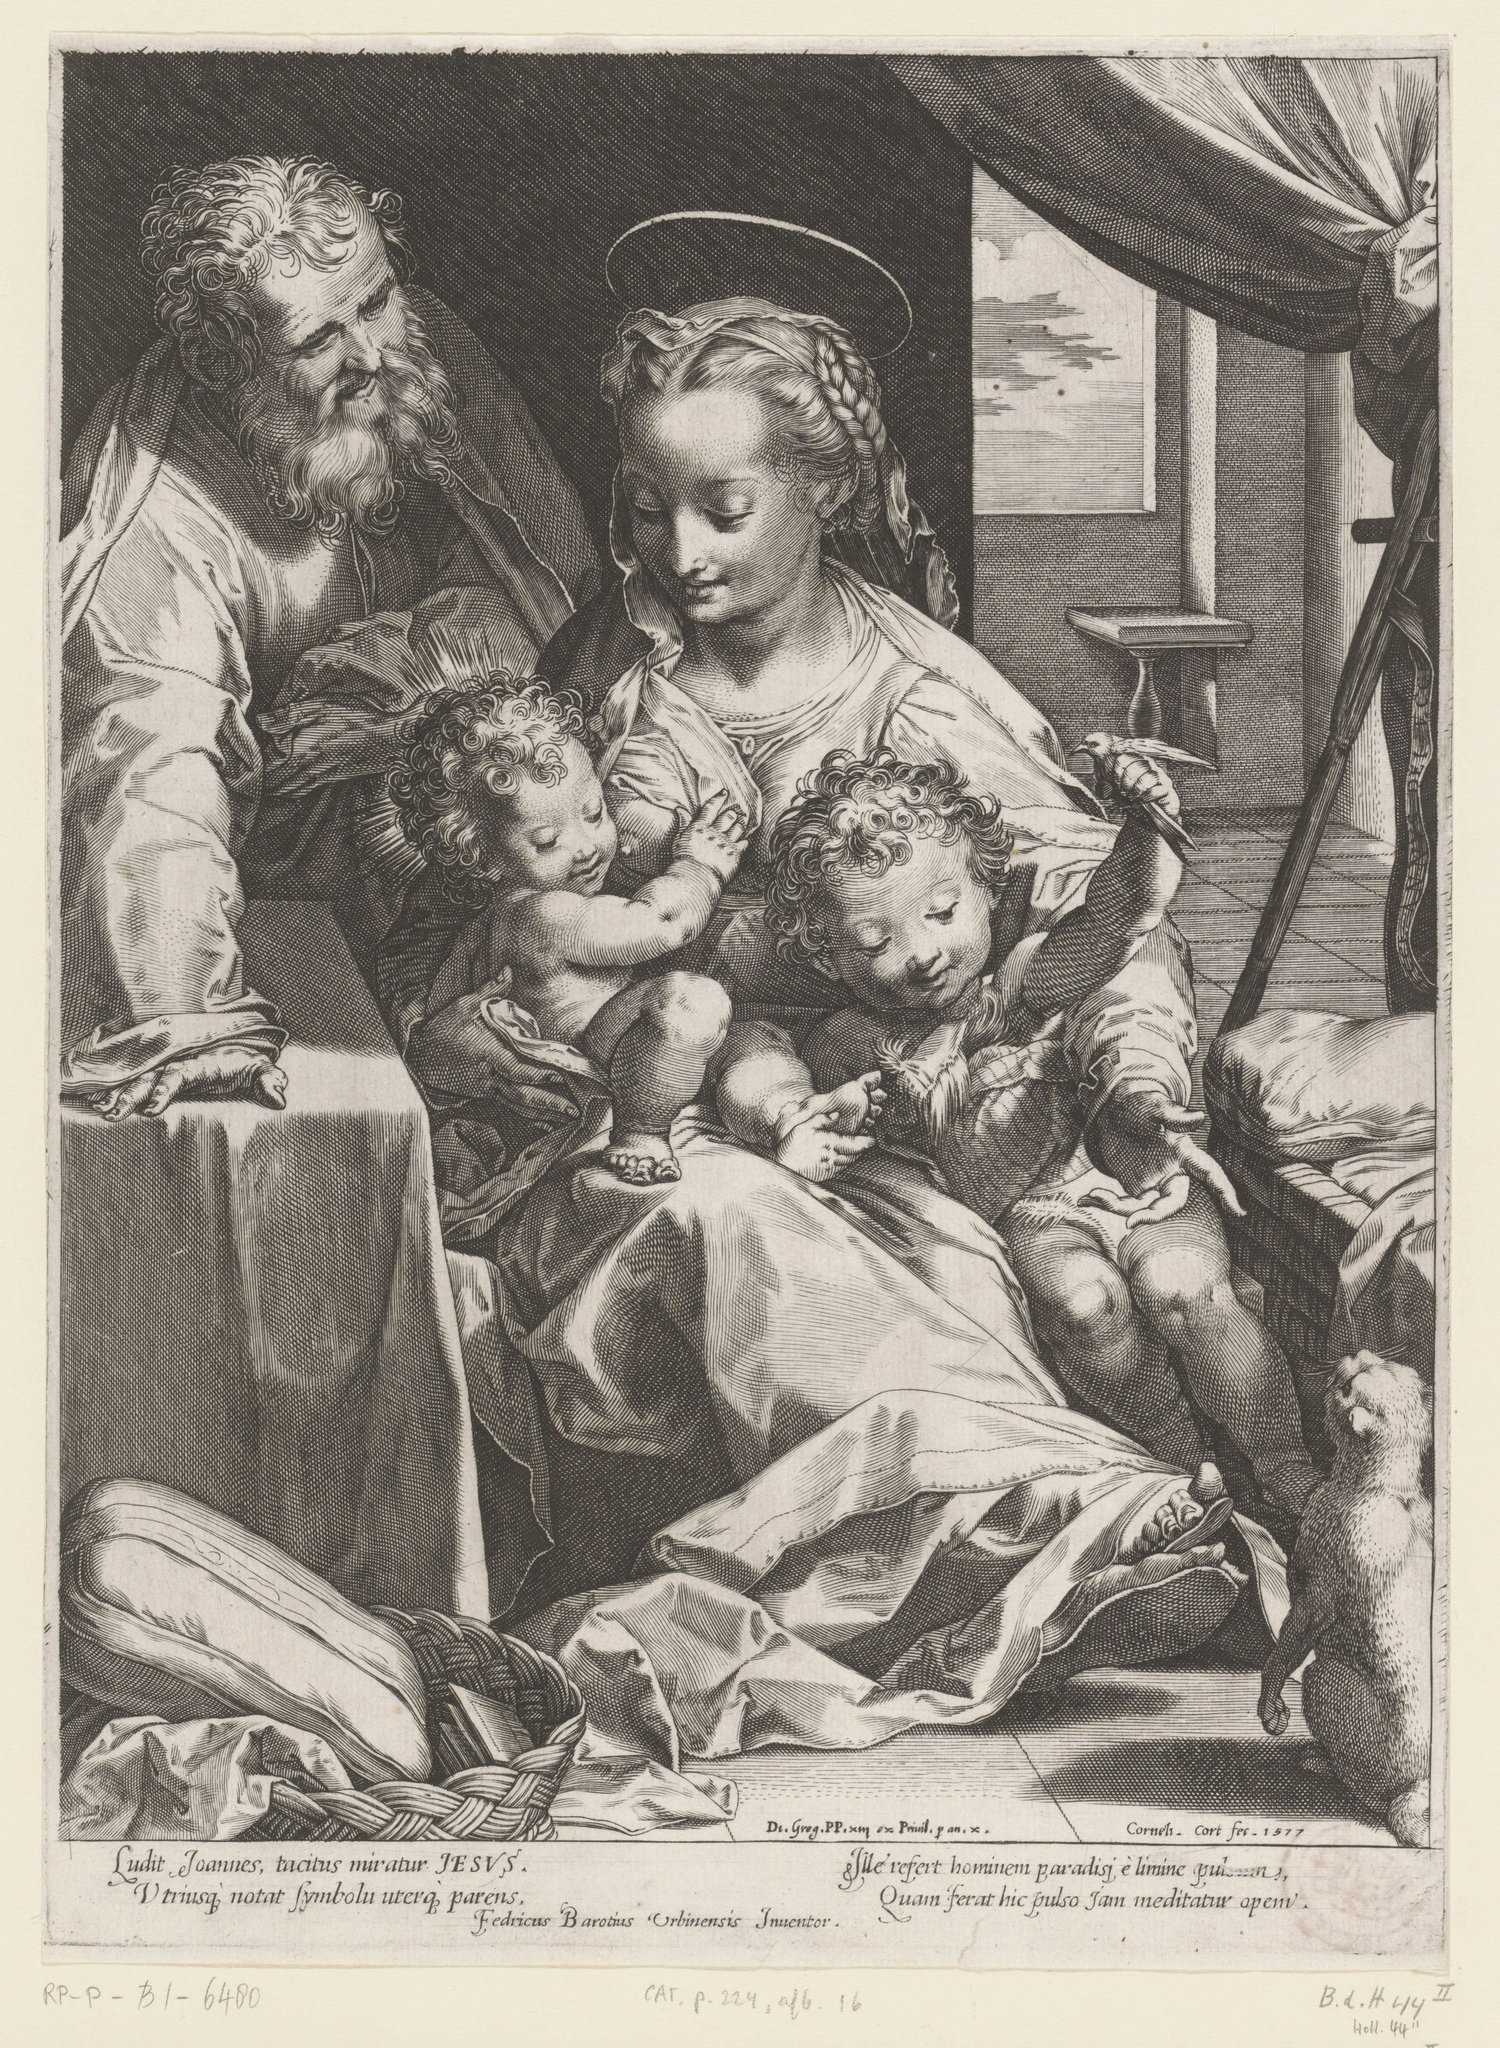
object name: print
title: Heilige Familie met Johannes de Doper en kat (La Madonna del Gatto)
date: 1577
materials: paper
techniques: engraving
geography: rome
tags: cat, holy family with john the baptist (as child)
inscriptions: signature: ‘Fedricus Barotius Urbinensis Inventor’, caption: ‘Ludit Joannes, tacitus miratur JESUS...hic pulso iam meditatur opem’, privilege: ‘Di. Greg. PP. xiij ex Privil. p[er] an.x.’, collector's mark: Lugt 240, inscription: ‘ECCE ANNUS DEI ECCE’, date: ‘1577’, signature: ‘Corneli. Cort fe.’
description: De Heilige Familie met Johannes de Doper als kind. Christus zit op Maria's schoot en grijpt naar haar borst. Johannes houdt een vogeltje in zijn hand en lokt een zittende poes. Rechts staat een staf tegen een bed, met banderol met de tekst: ECCE ANNUS DEI ECCE.